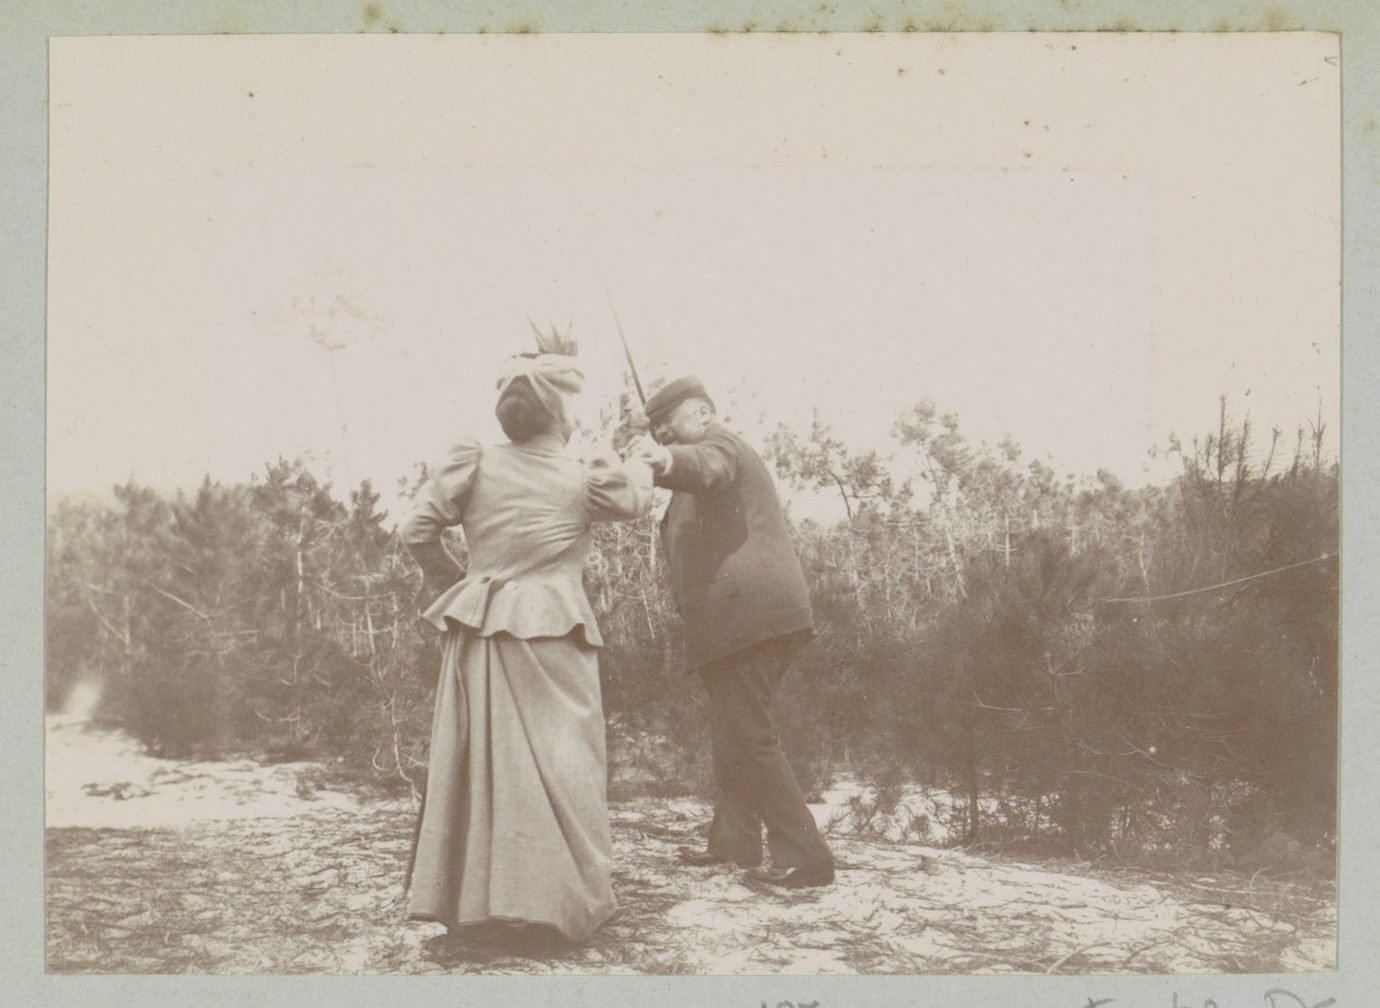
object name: photograph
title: Man en een vrouw, vermoedelijk dansend op een pad bij Arcachon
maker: delizy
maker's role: manufacturer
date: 1897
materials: paper, photographic support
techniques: gelatin silver print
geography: arcachon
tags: adult woman, dancing, adult man, road, path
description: Onderdeel van Fotoalbum van een Franse amateurfotograaf met opnames van uitstapjes in Frankrijk, Spanje, België, Luxemburg en Nederland, de eerste automobielen en autoraces.